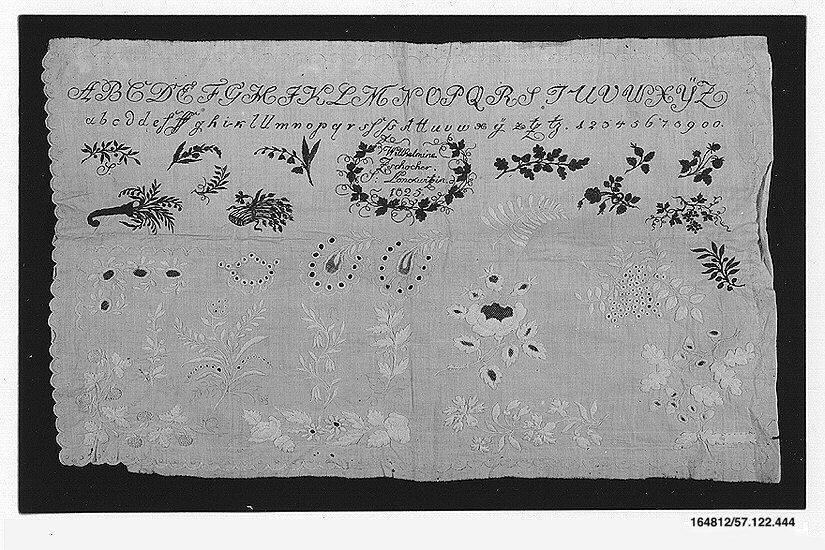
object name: sampler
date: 1825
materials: cotton, linen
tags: flowers